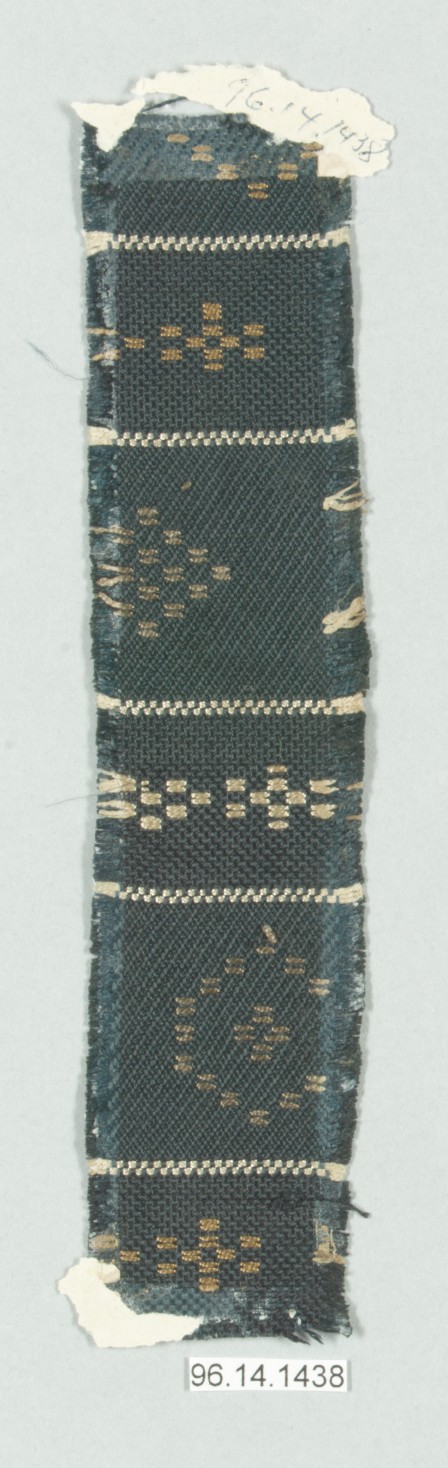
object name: piece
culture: japanese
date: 1801-1900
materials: silk